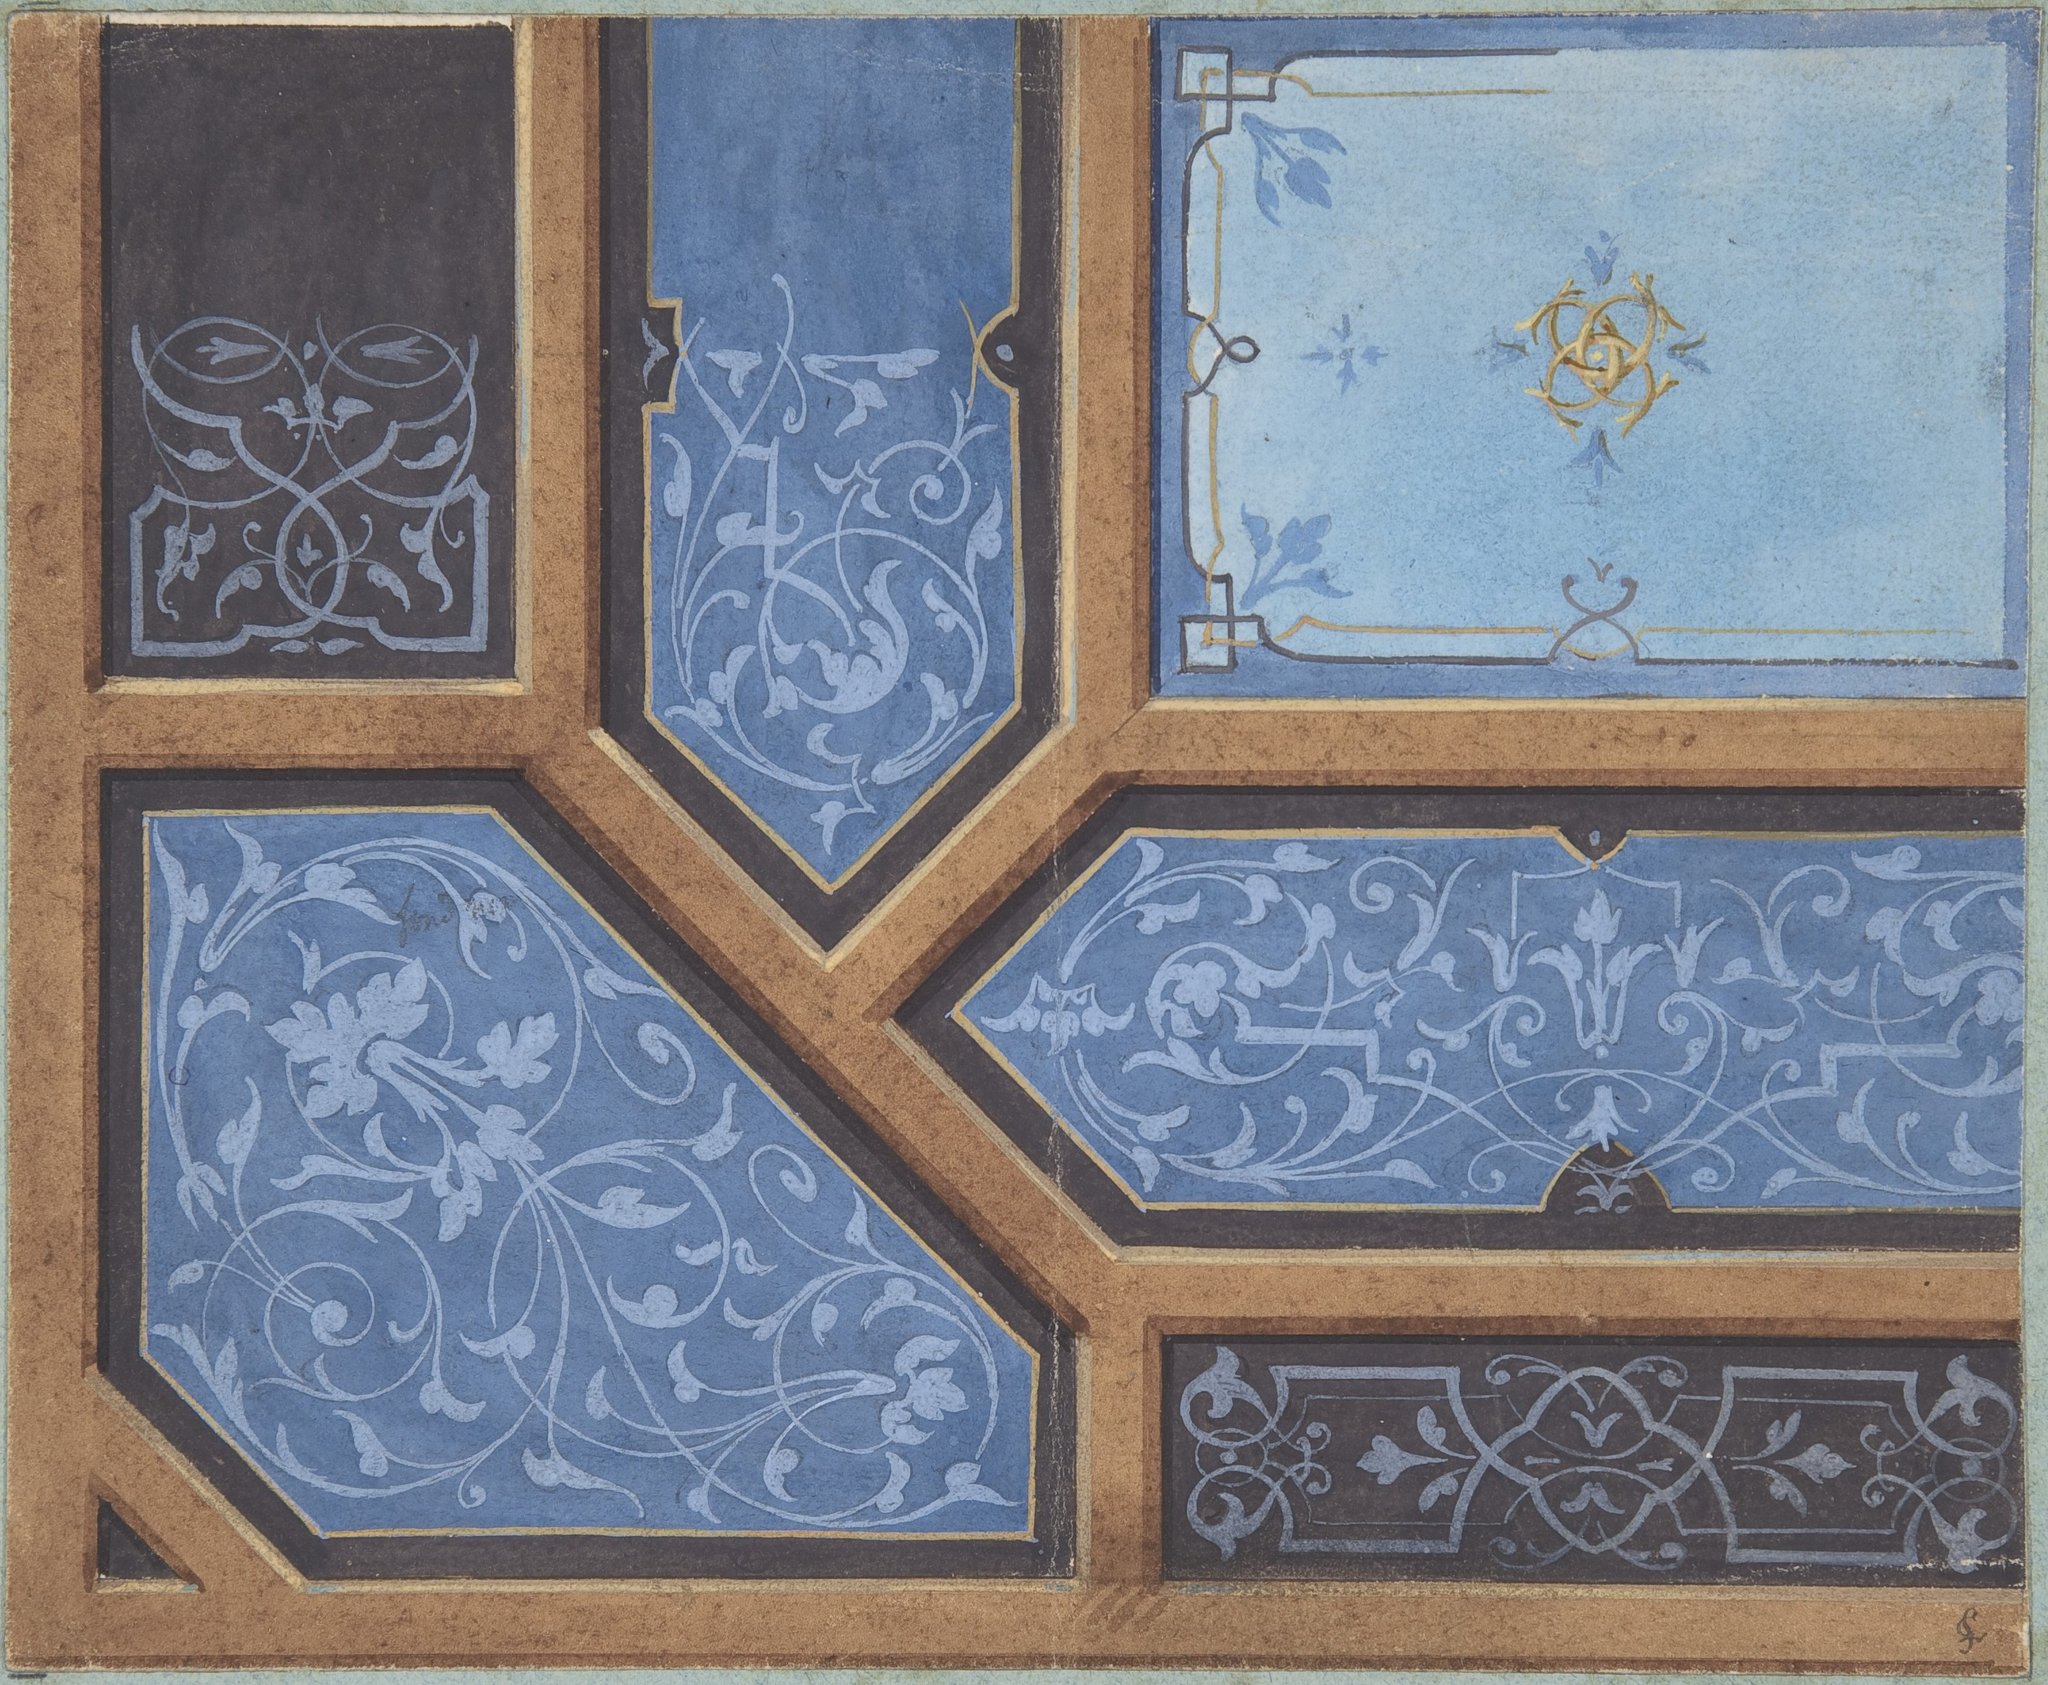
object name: drawing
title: Design for Dining Room Ceiling, Château de Cangé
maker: jules-edmond-charles lachaise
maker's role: artist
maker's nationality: french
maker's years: 1897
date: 1851-1900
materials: gouache, ink, watercolor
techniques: pen